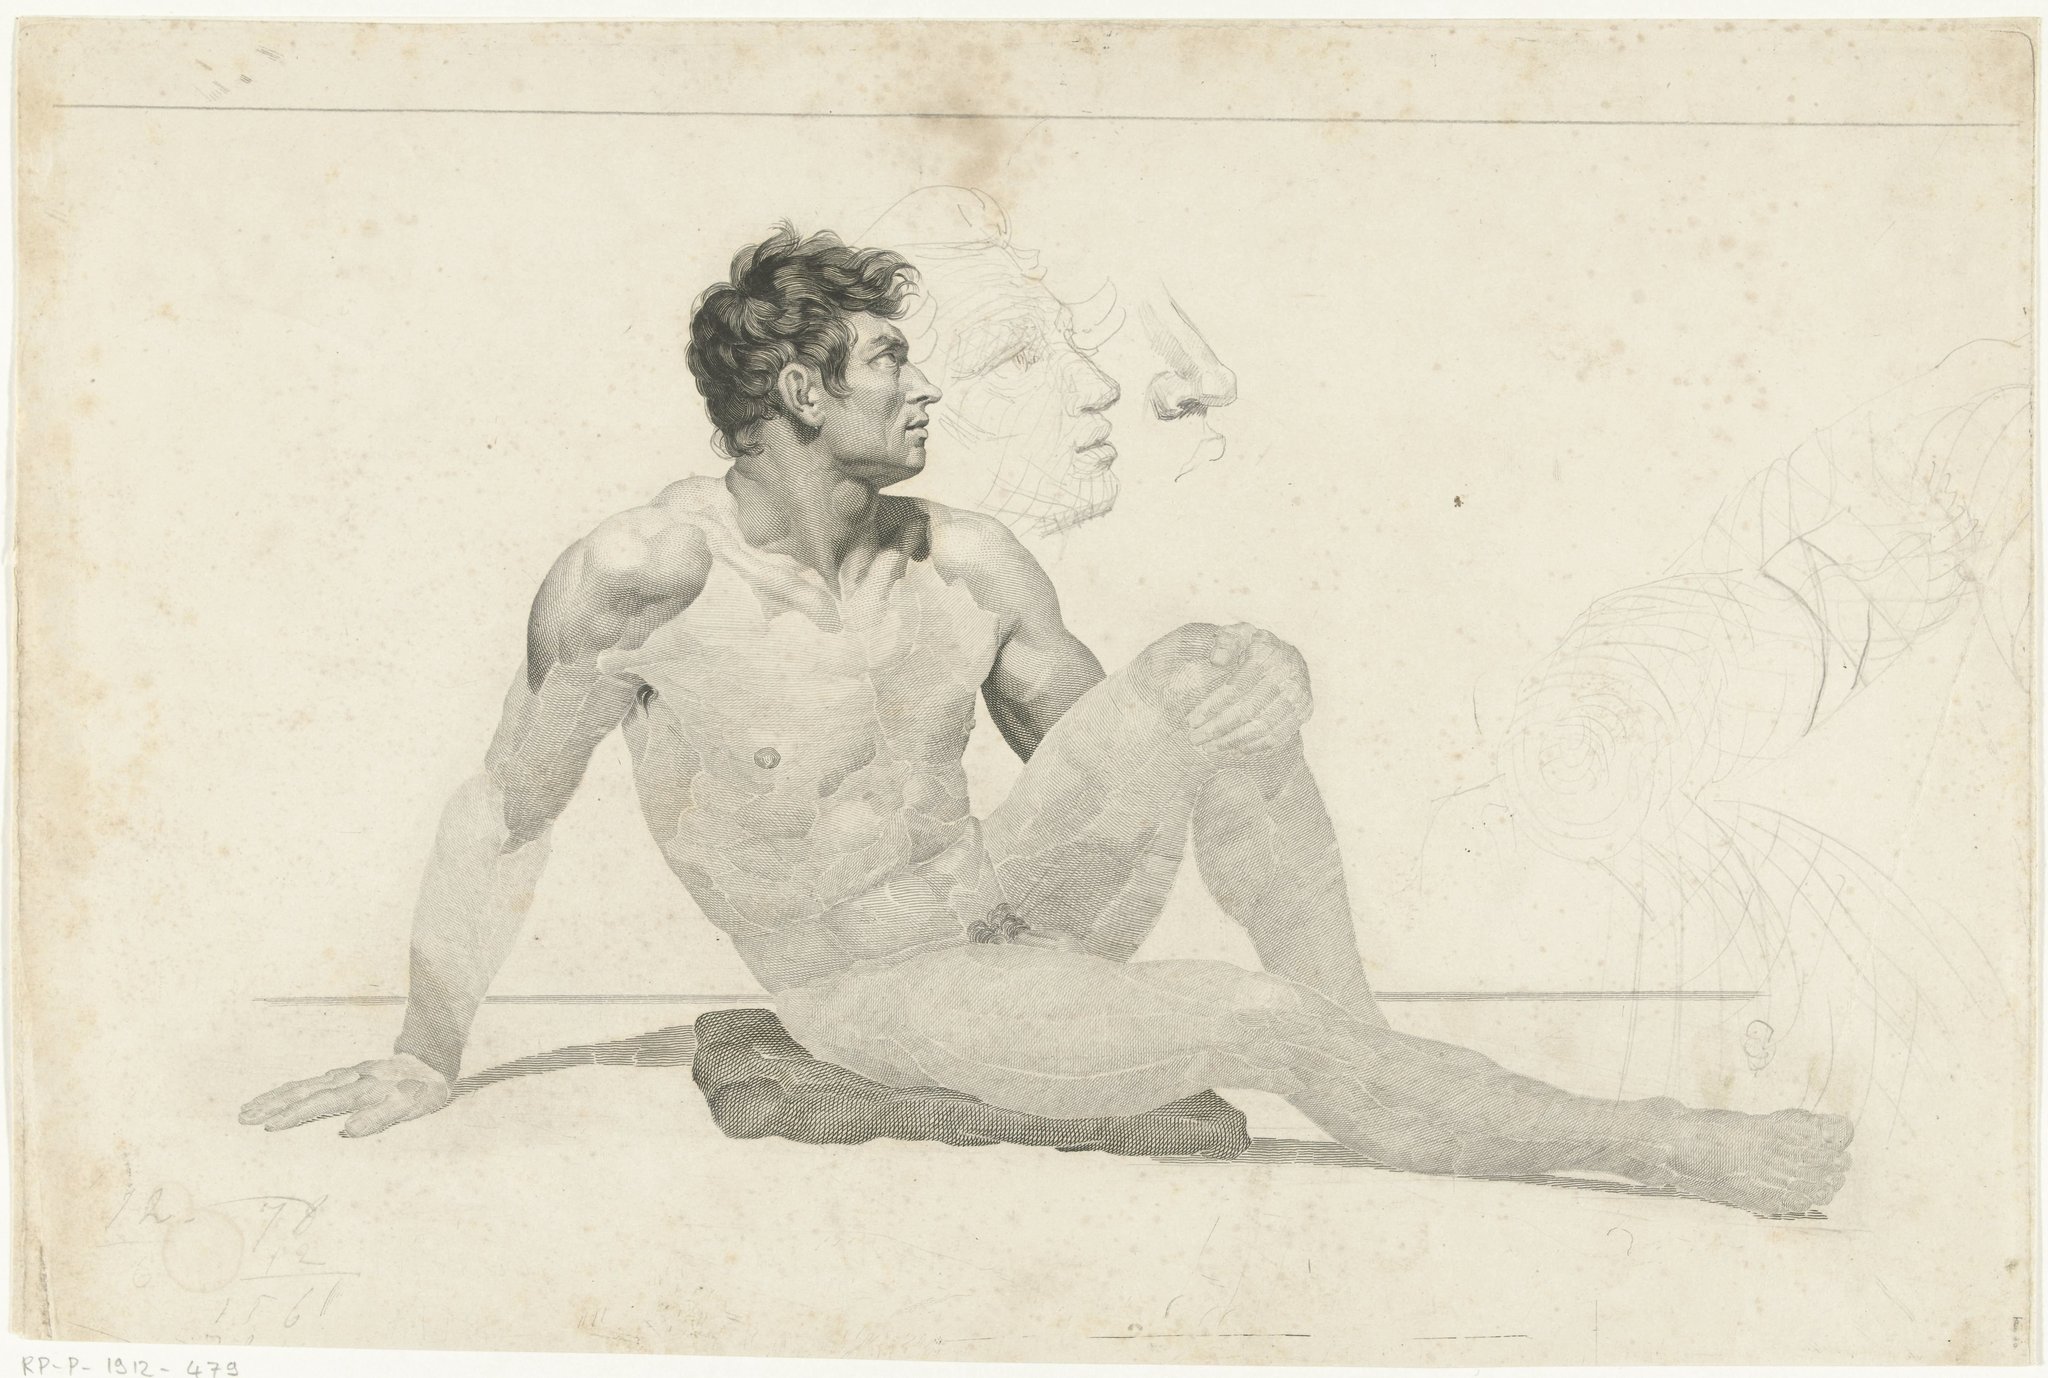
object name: print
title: Naakte zittende man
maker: henricus wilhelmus couwenberg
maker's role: draughtsman, print maker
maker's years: 1814-1845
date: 1829-1845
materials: paper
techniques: engraving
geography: amsterdam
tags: the (nude) human figure; 'corpo humano' (ripa) (+ sitting on the ground)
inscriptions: collector's mark: Lugt 2228